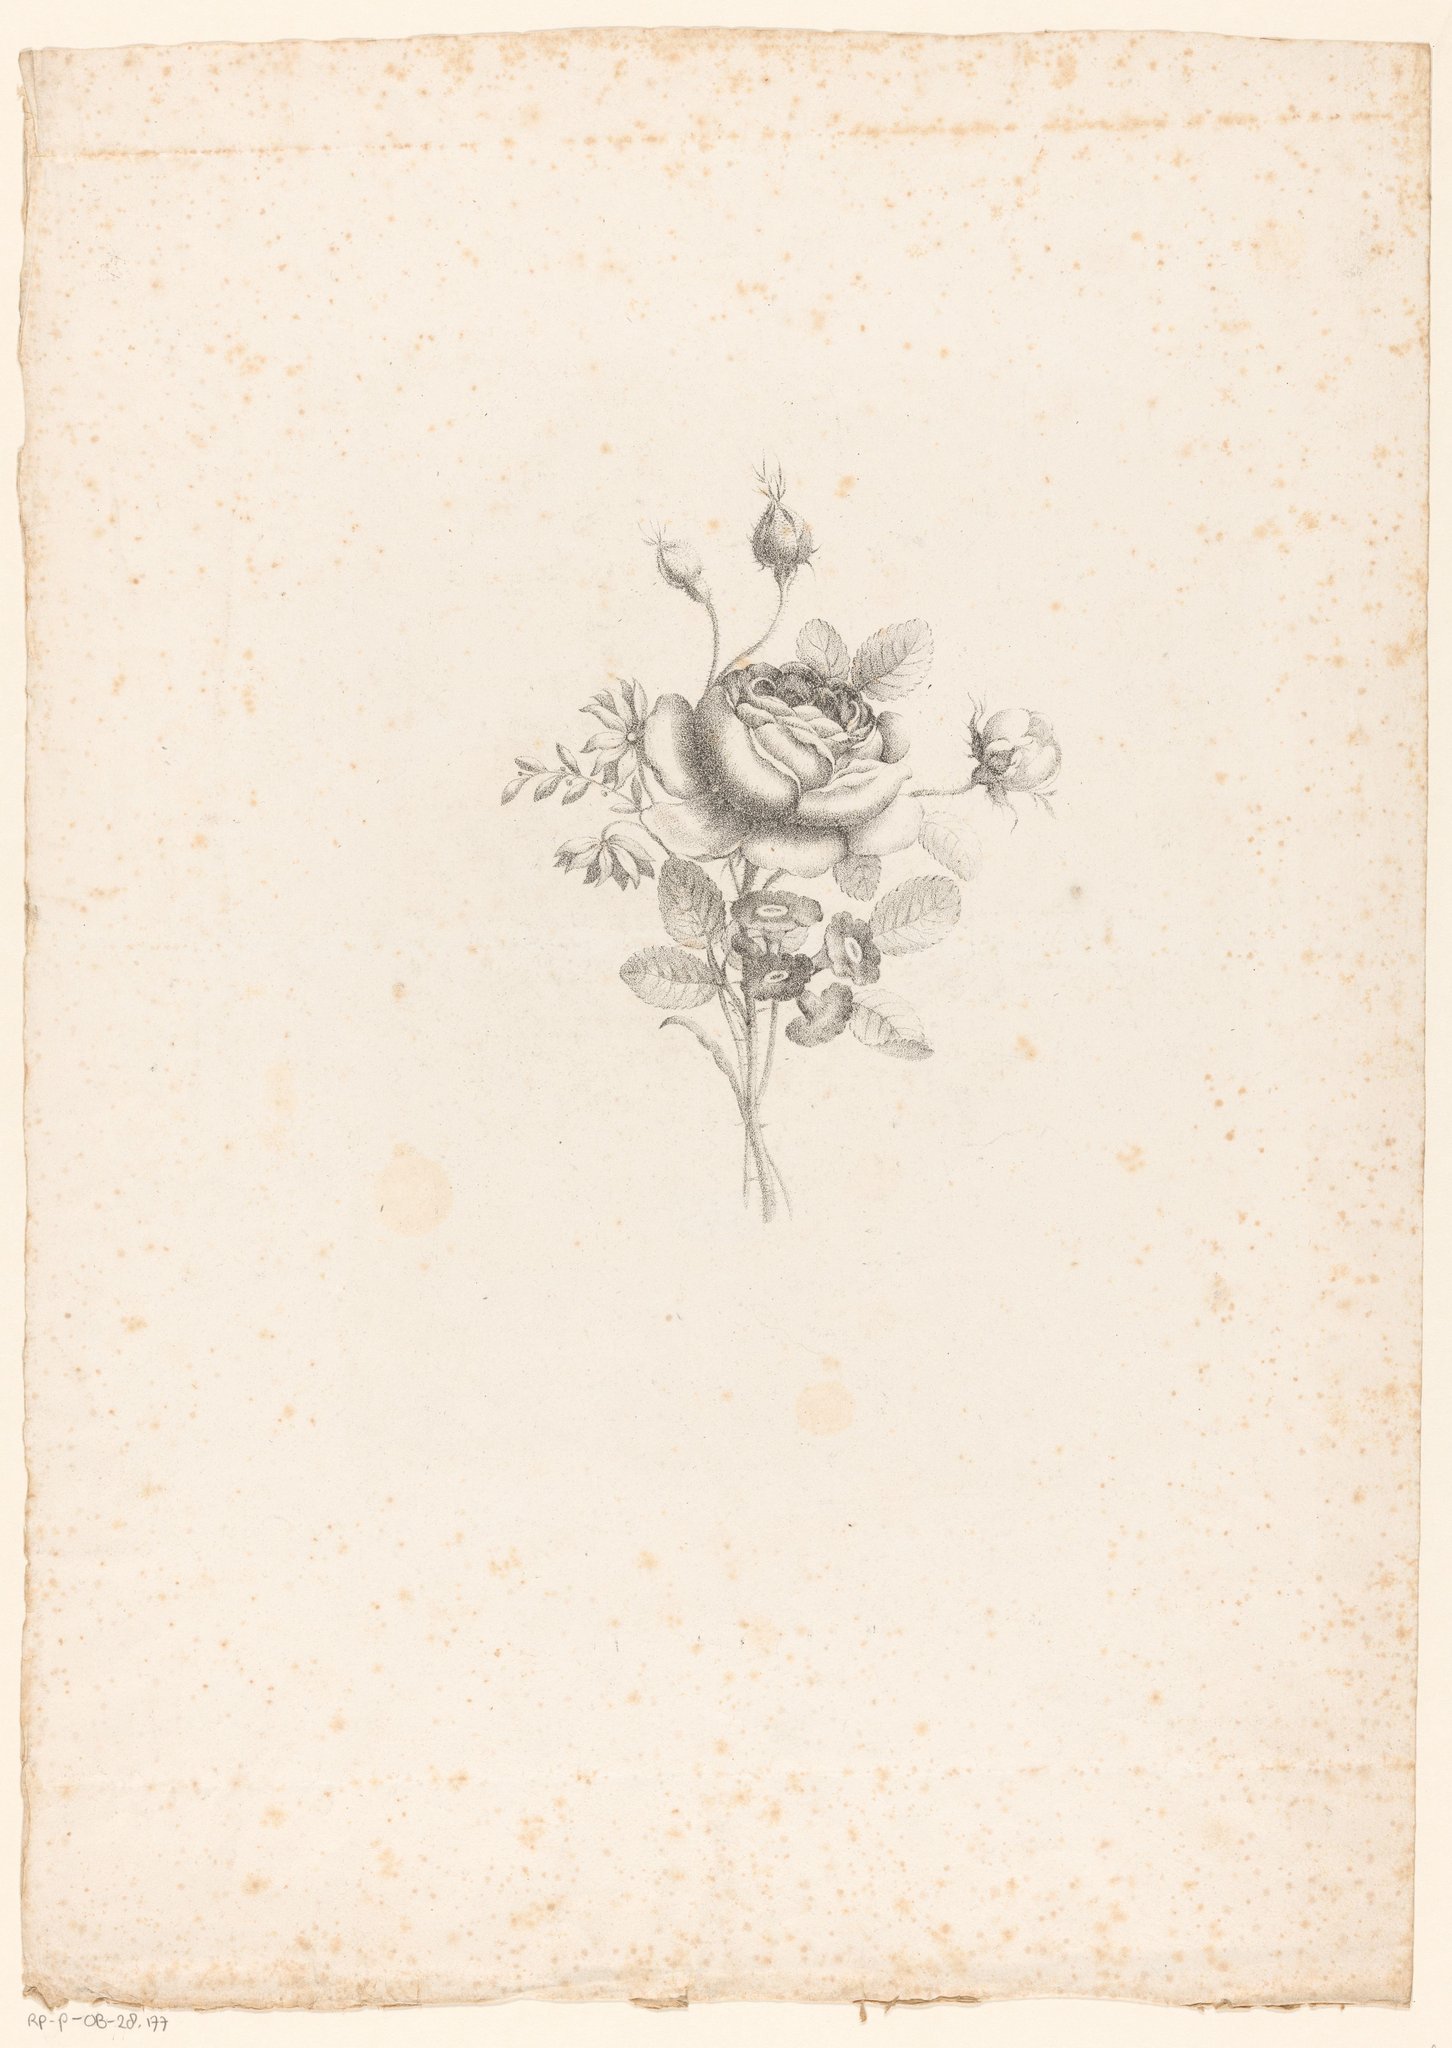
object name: print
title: Boeket bloemen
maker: Anonymous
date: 1809-1899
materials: paper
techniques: lithograph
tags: cut flowers; nosegay, bunch of flowers, flowers: rose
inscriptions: collector's mark: Lugt 2228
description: In het midden van het kleine boeket prijkt een roos.